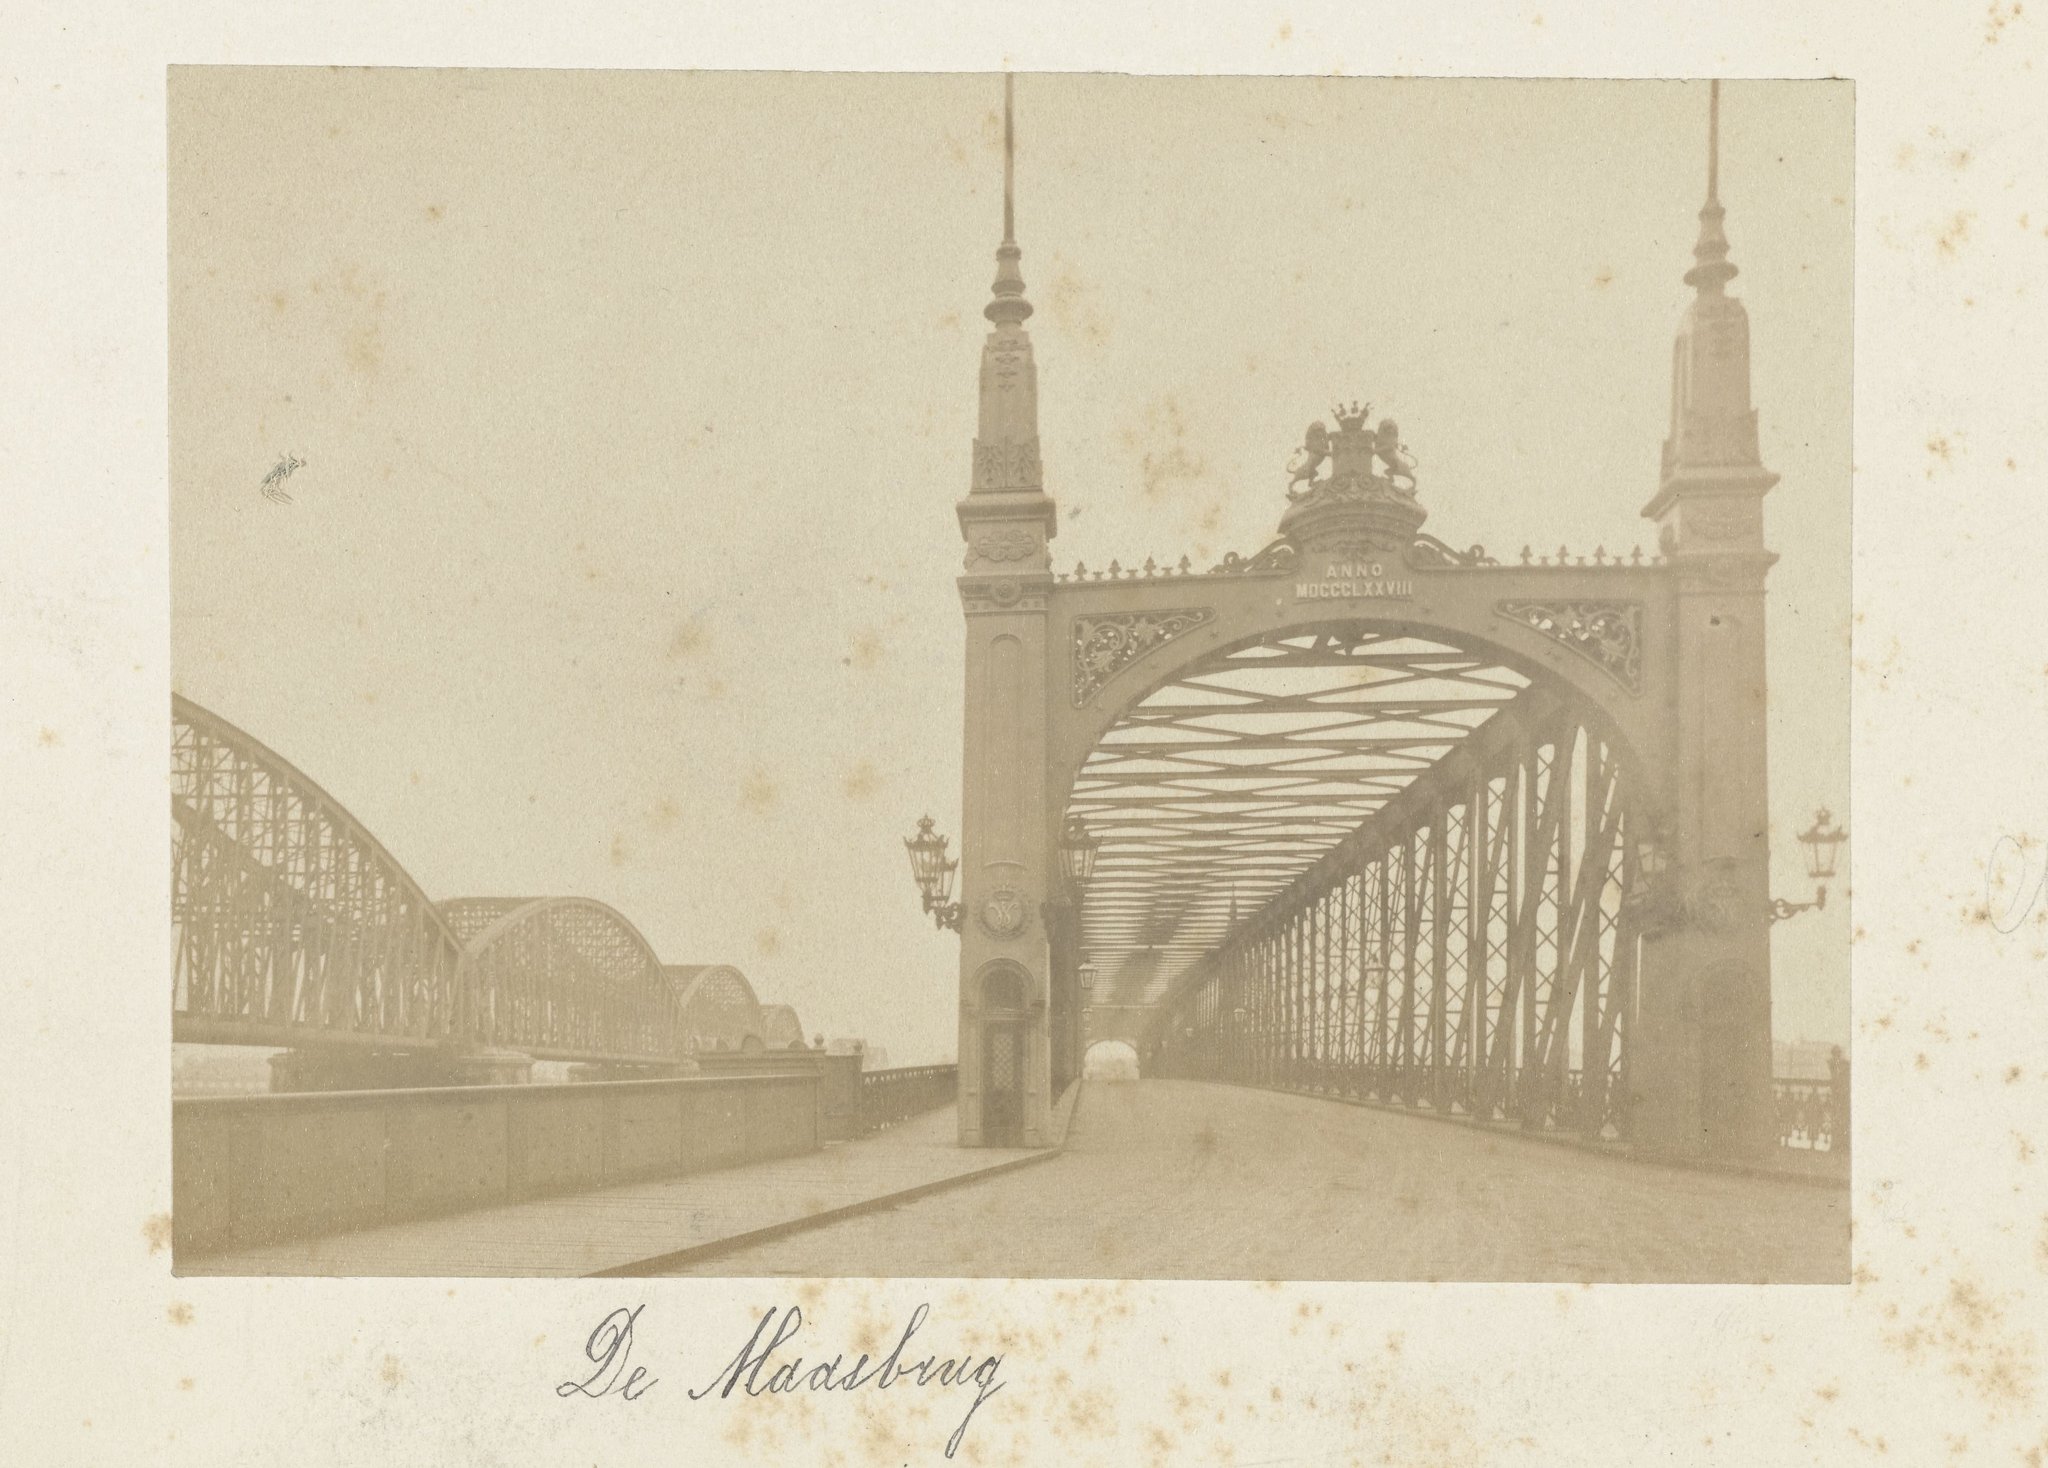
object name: photograph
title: De Maasbrug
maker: Anonymous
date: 1880-1900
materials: paper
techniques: albumen print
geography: netherlands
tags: bridge in city across river, canal, etc.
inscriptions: title: ‘De Maasbrug’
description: De Willemsbrug is ontworpen door C.B. van der Tak